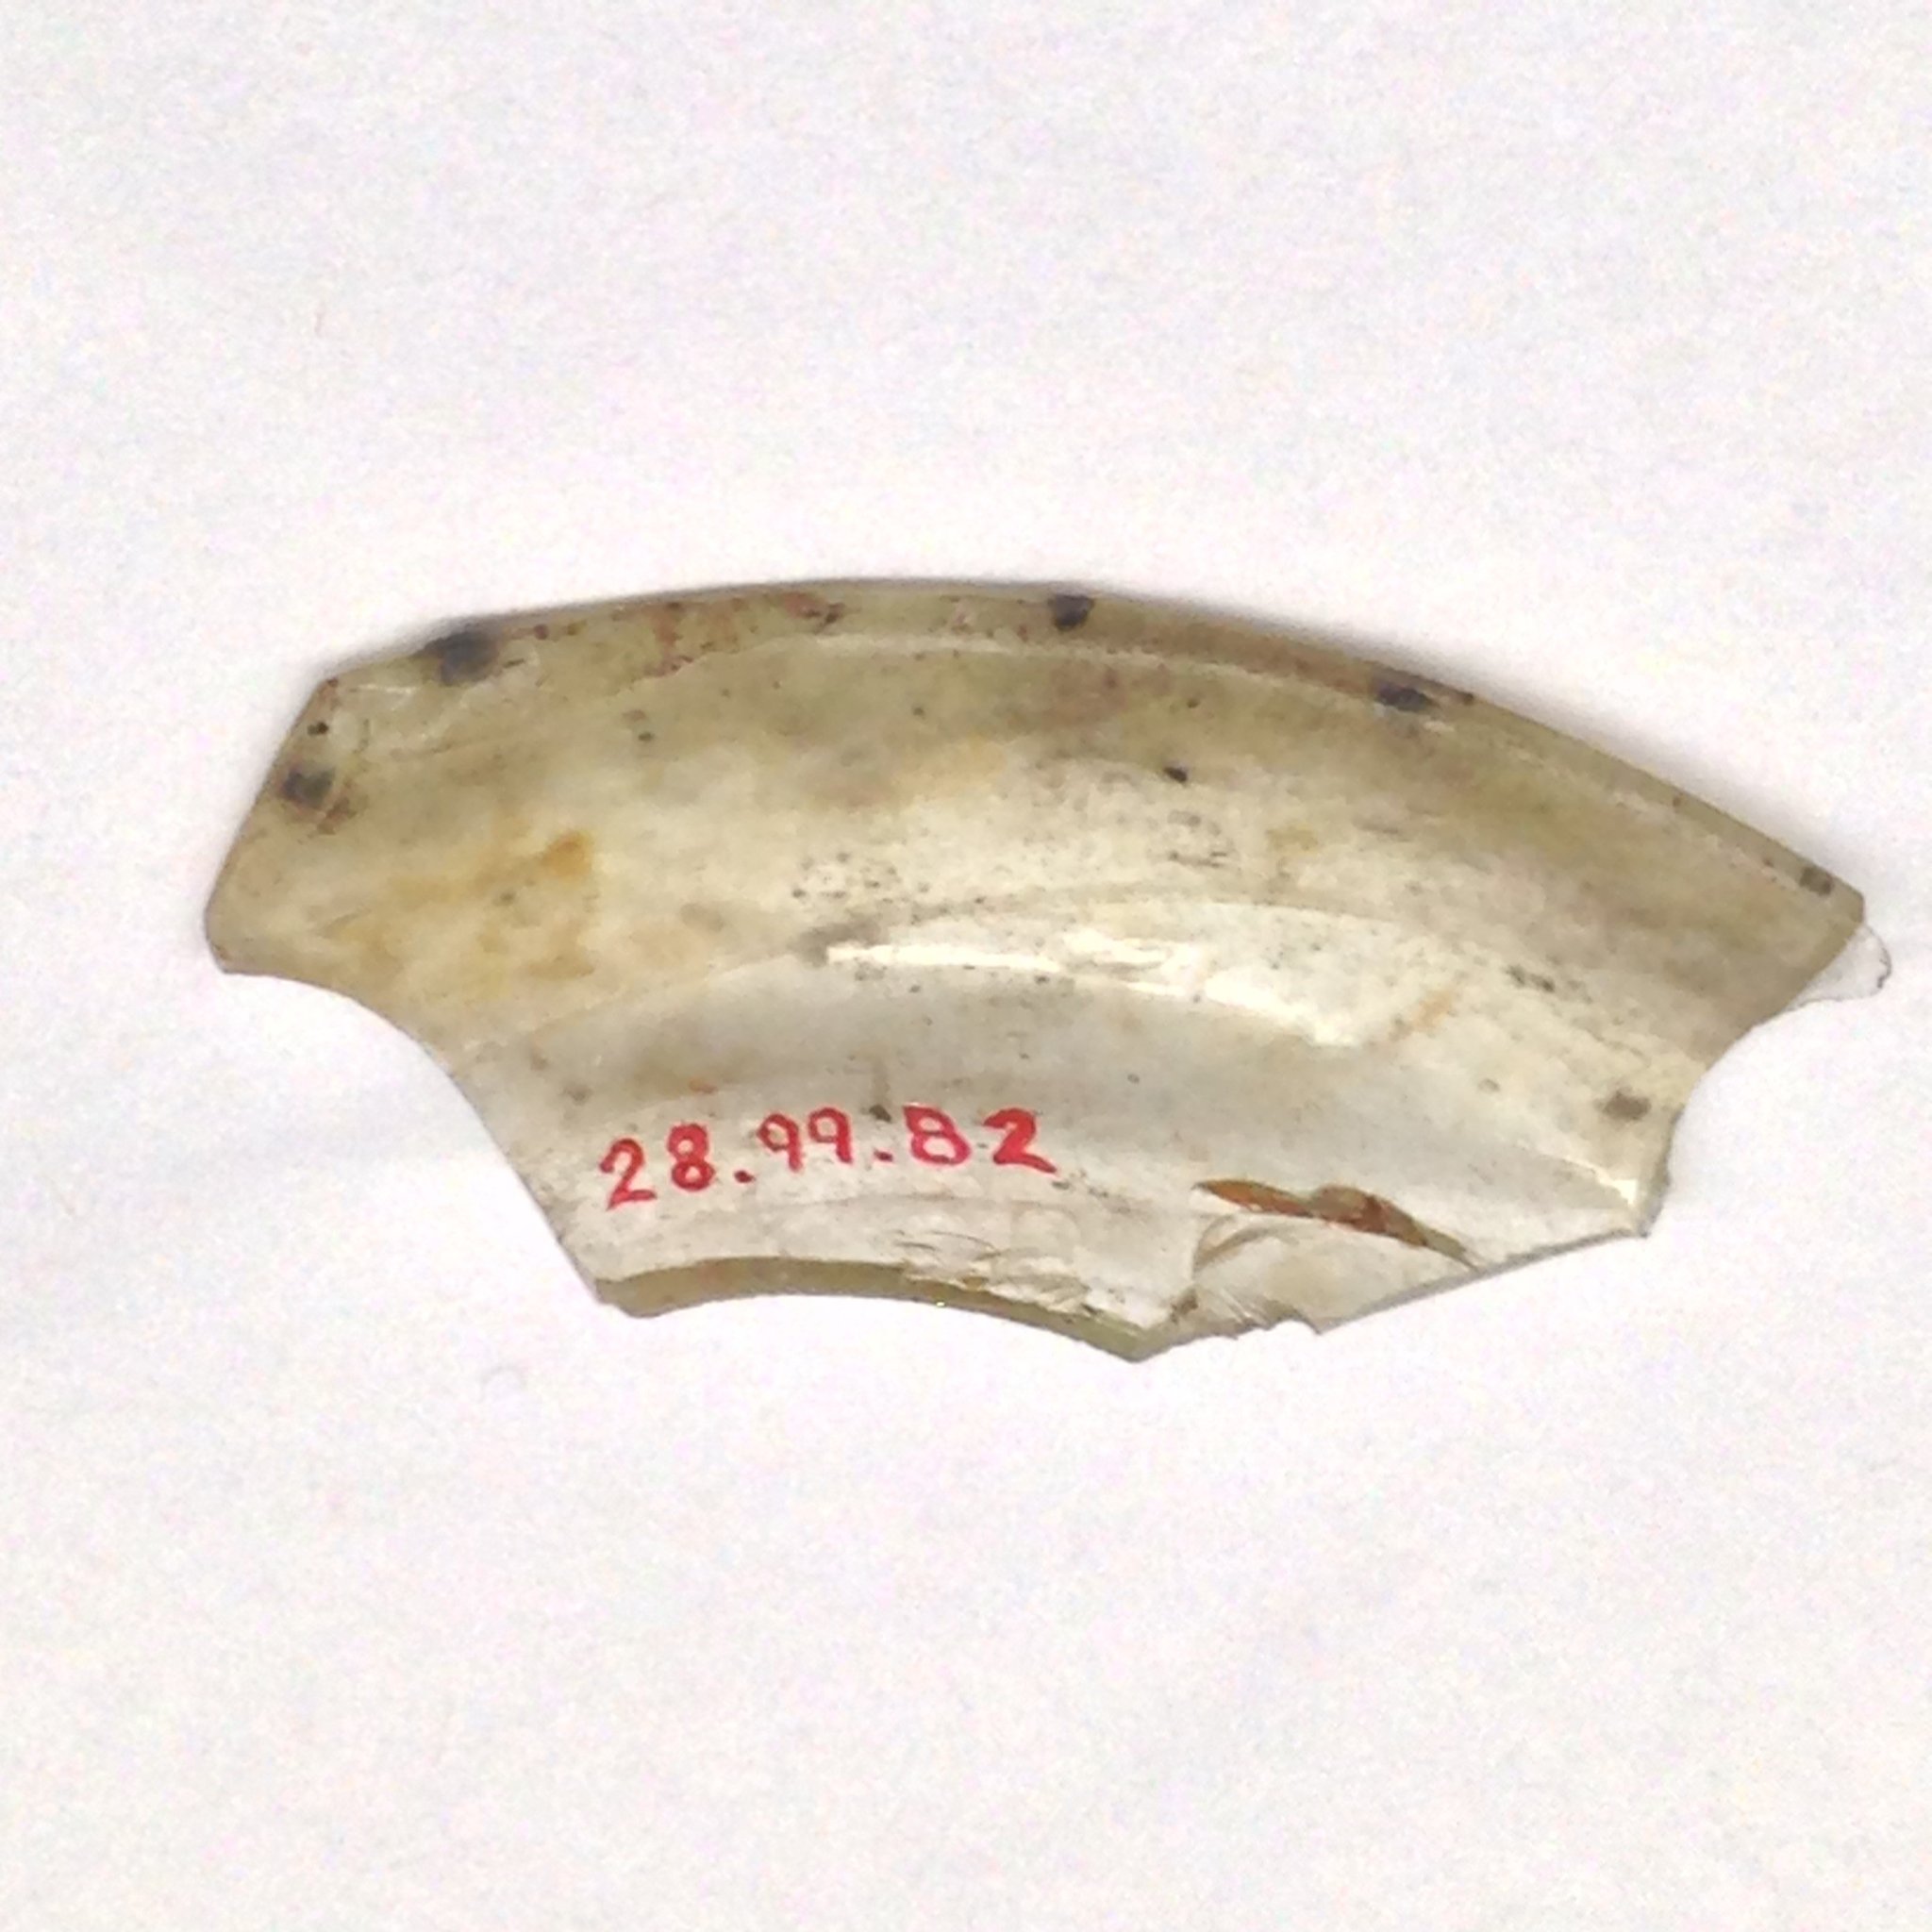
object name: fragment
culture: european or middle eastern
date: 1150-1250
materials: ceramic, glass